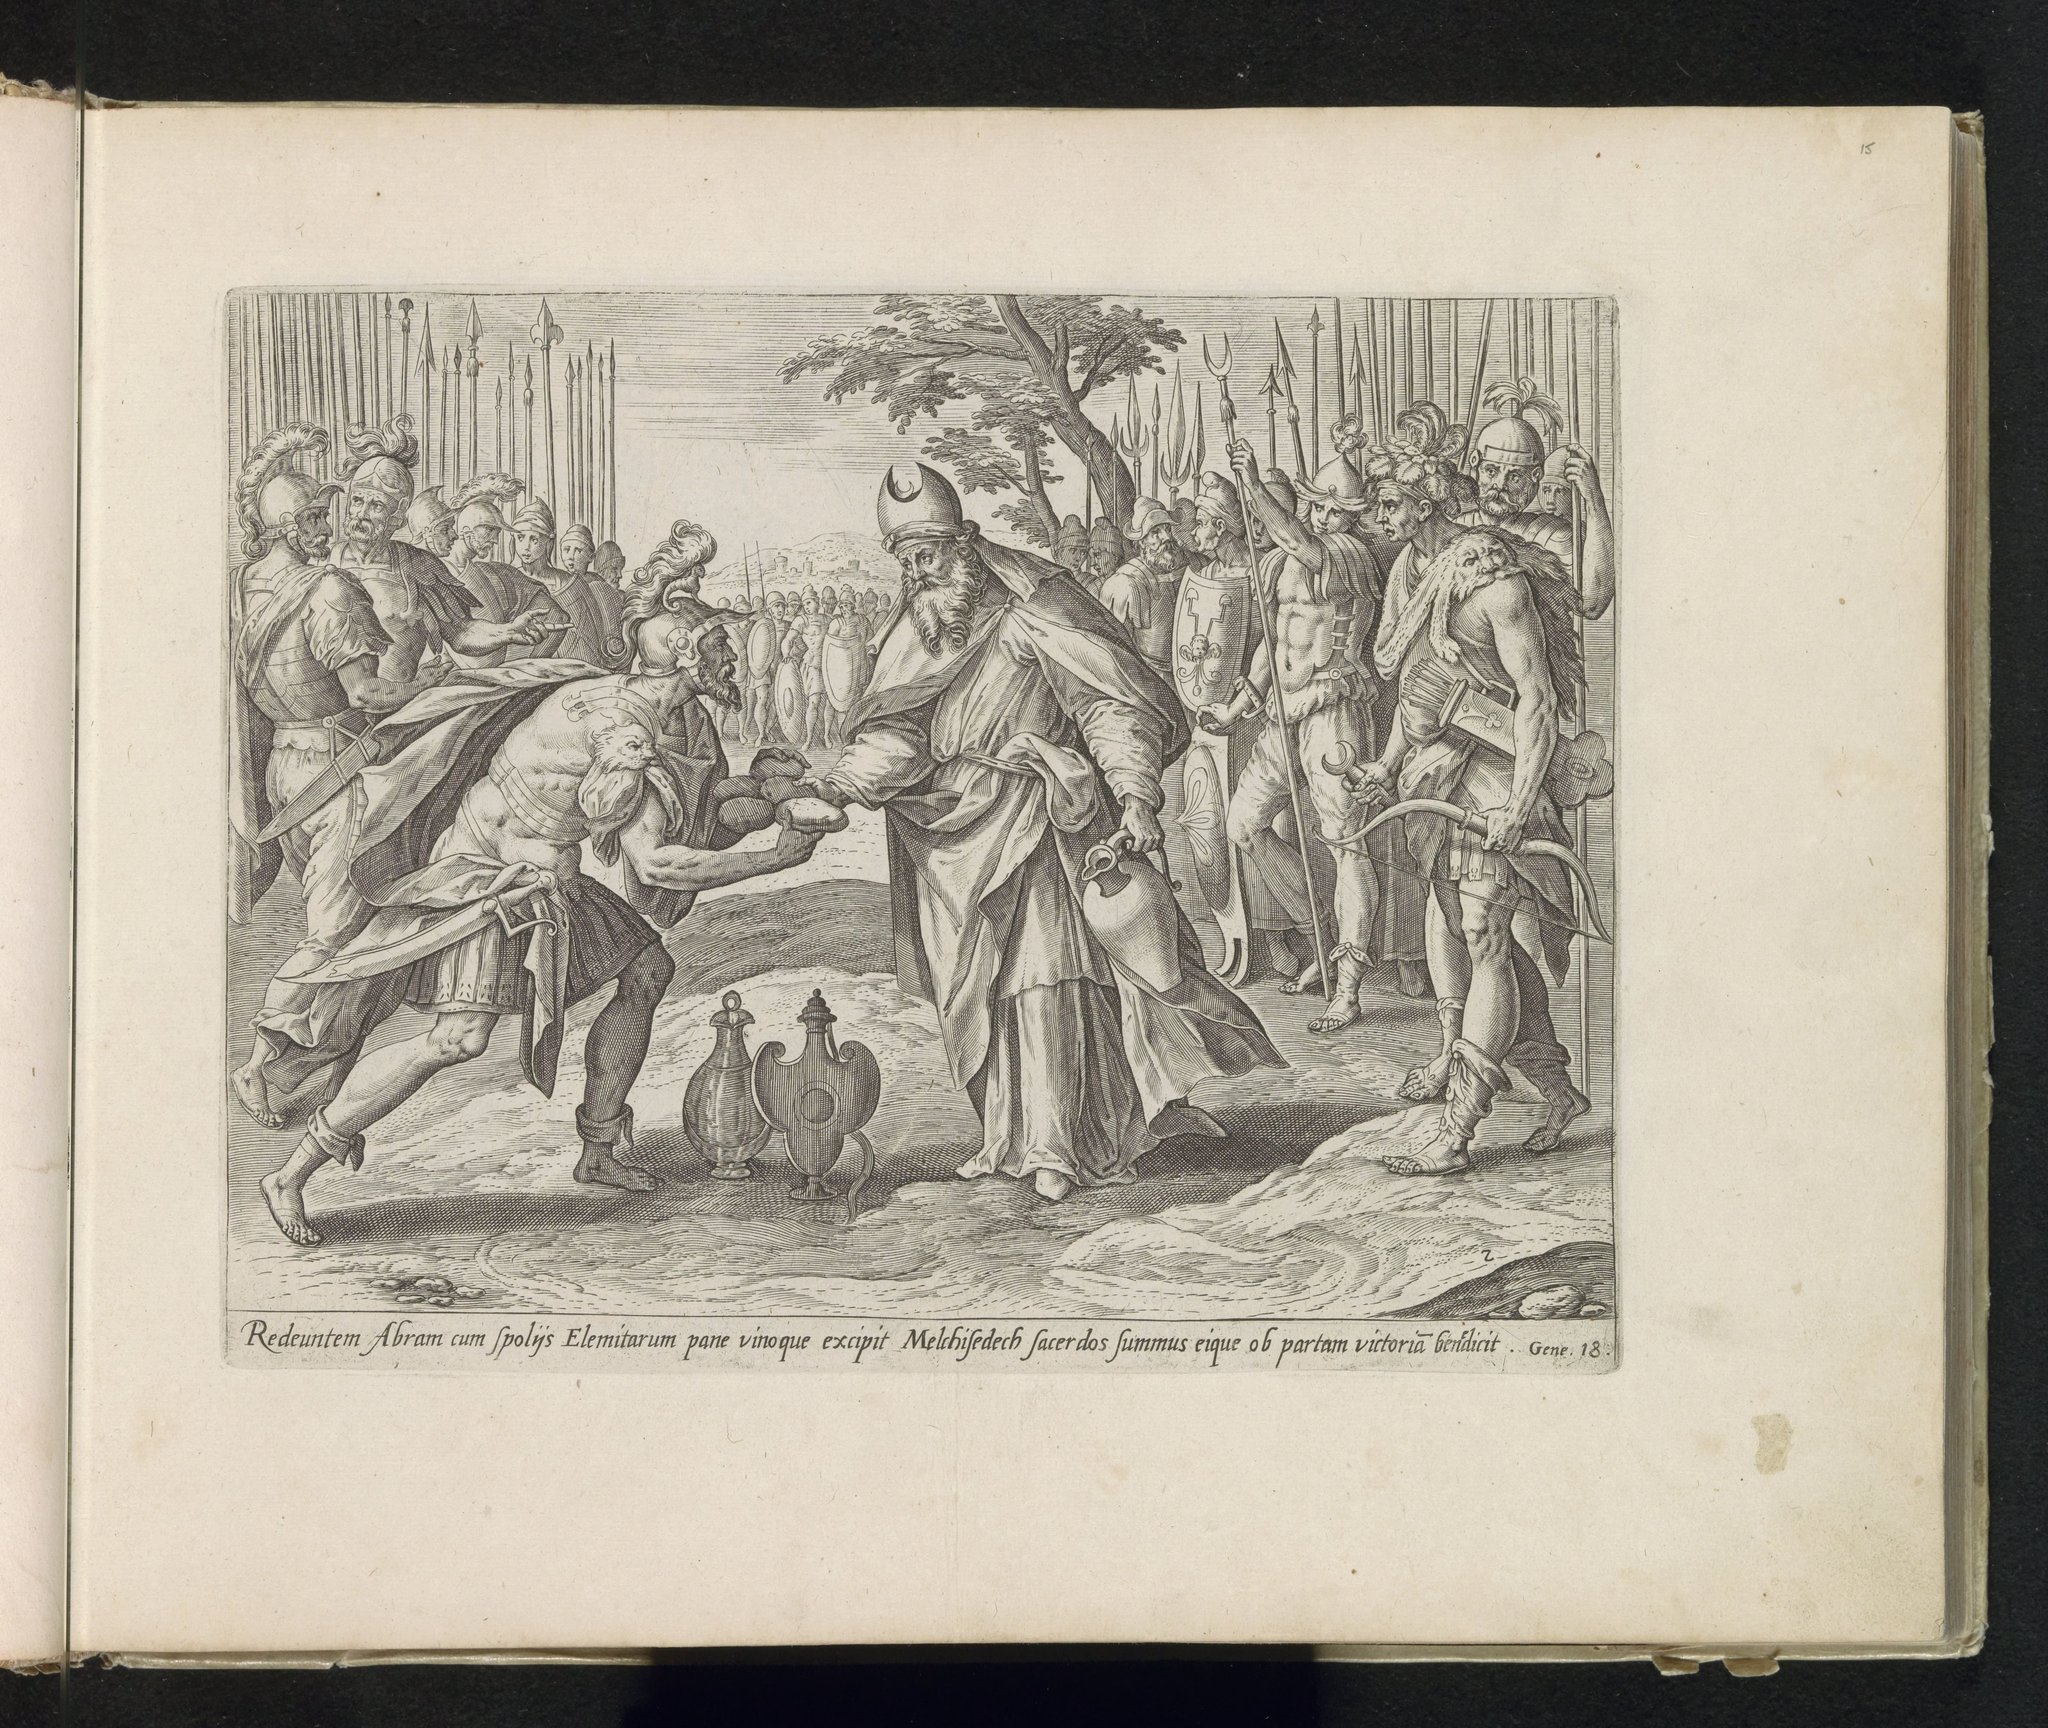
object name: print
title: Abrahams ontmoeting met Melchisedek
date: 1585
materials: paper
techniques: engraving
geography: antwerp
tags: the meeting of abraham and melchizedek, the high priest and king of salem, who brings bread and wine (genesis 14:18-20)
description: Melchisedek, de hogepriester en koning van Salem (Jeruzalem), geeft Abraham brood en een kan met wijn. Abraham, gekleed in harnas en met helm op het hoofd, neemt het brood aan, terwijl achter hem zijn soldaten staan. Achter Melchisedek staat zijn leger. Onder de voorstelling een verklarende tekst in het Latijn en een foutieve verwijzing naar een Bijbeltekst in Gen. 18. Deze prent maakt deel uit van een album.